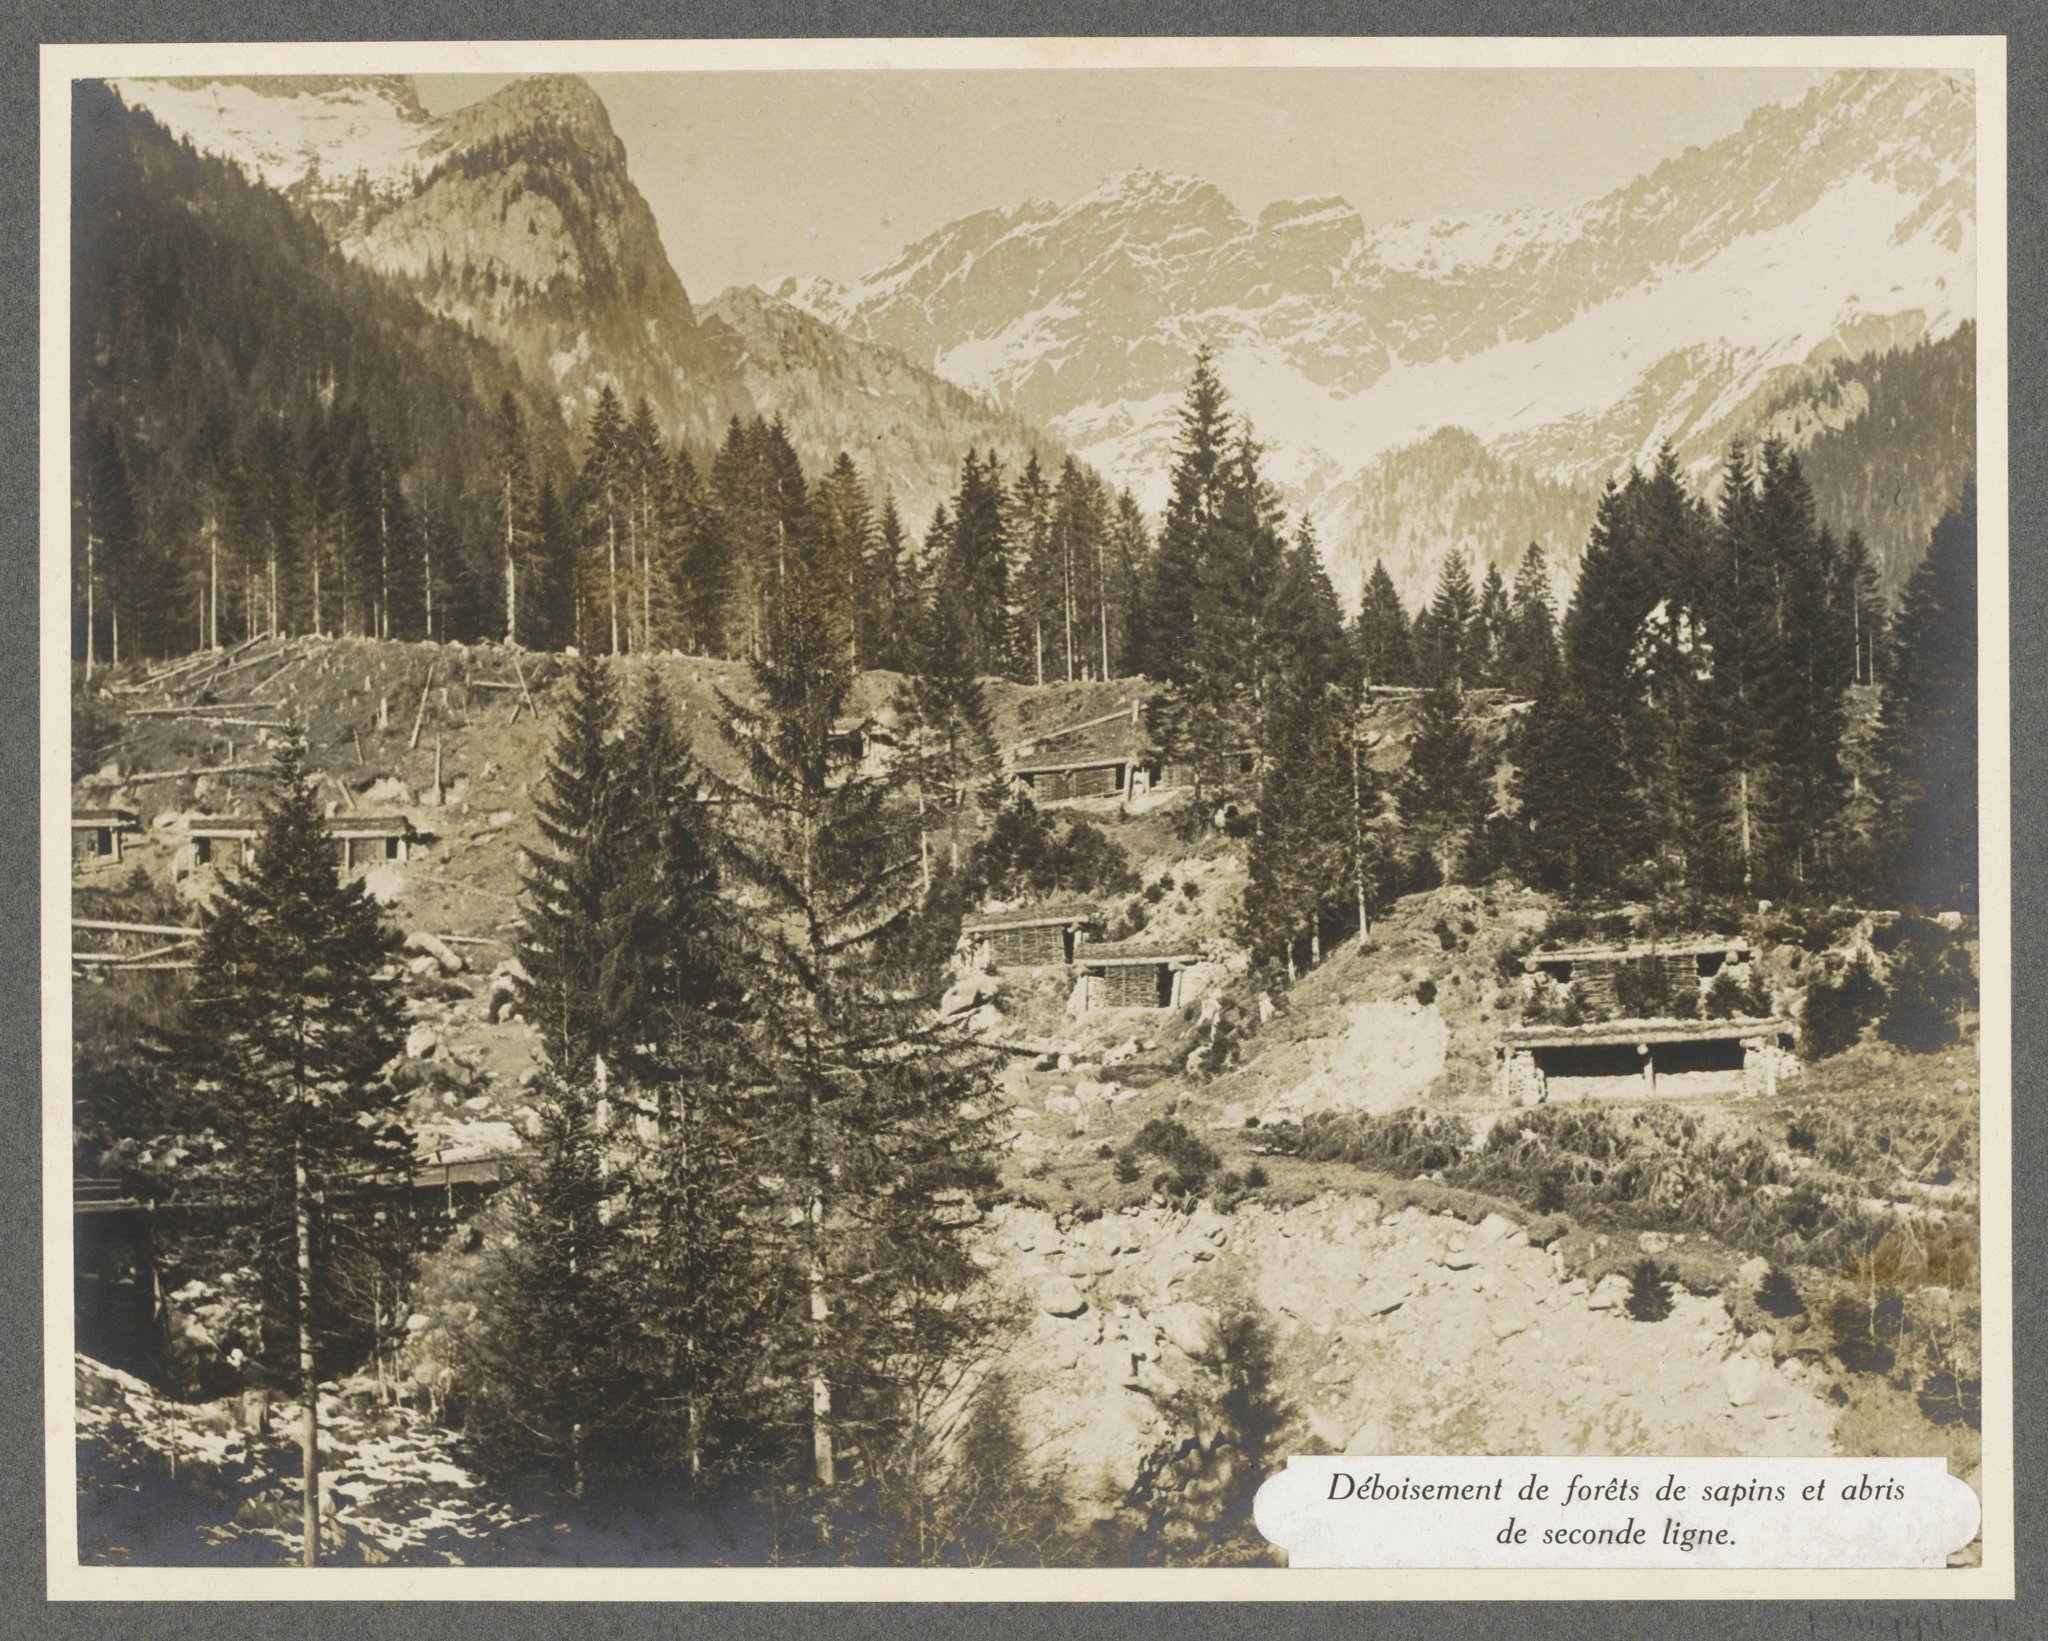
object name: photograph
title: Déboisement de forêts de sapins et abris de seconde ligne.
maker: henri de rothschild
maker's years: 1872-1947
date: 1916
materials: photographic support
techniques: gelatin silver print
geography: dolomites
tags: war (+ land forces), shelter ~ military service (+ warfare in forest), mountain-range, snow peaks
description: Onderdeel van Fotoalbum Medische missie H. de Rothschild naar het Italiaanse front 1916.